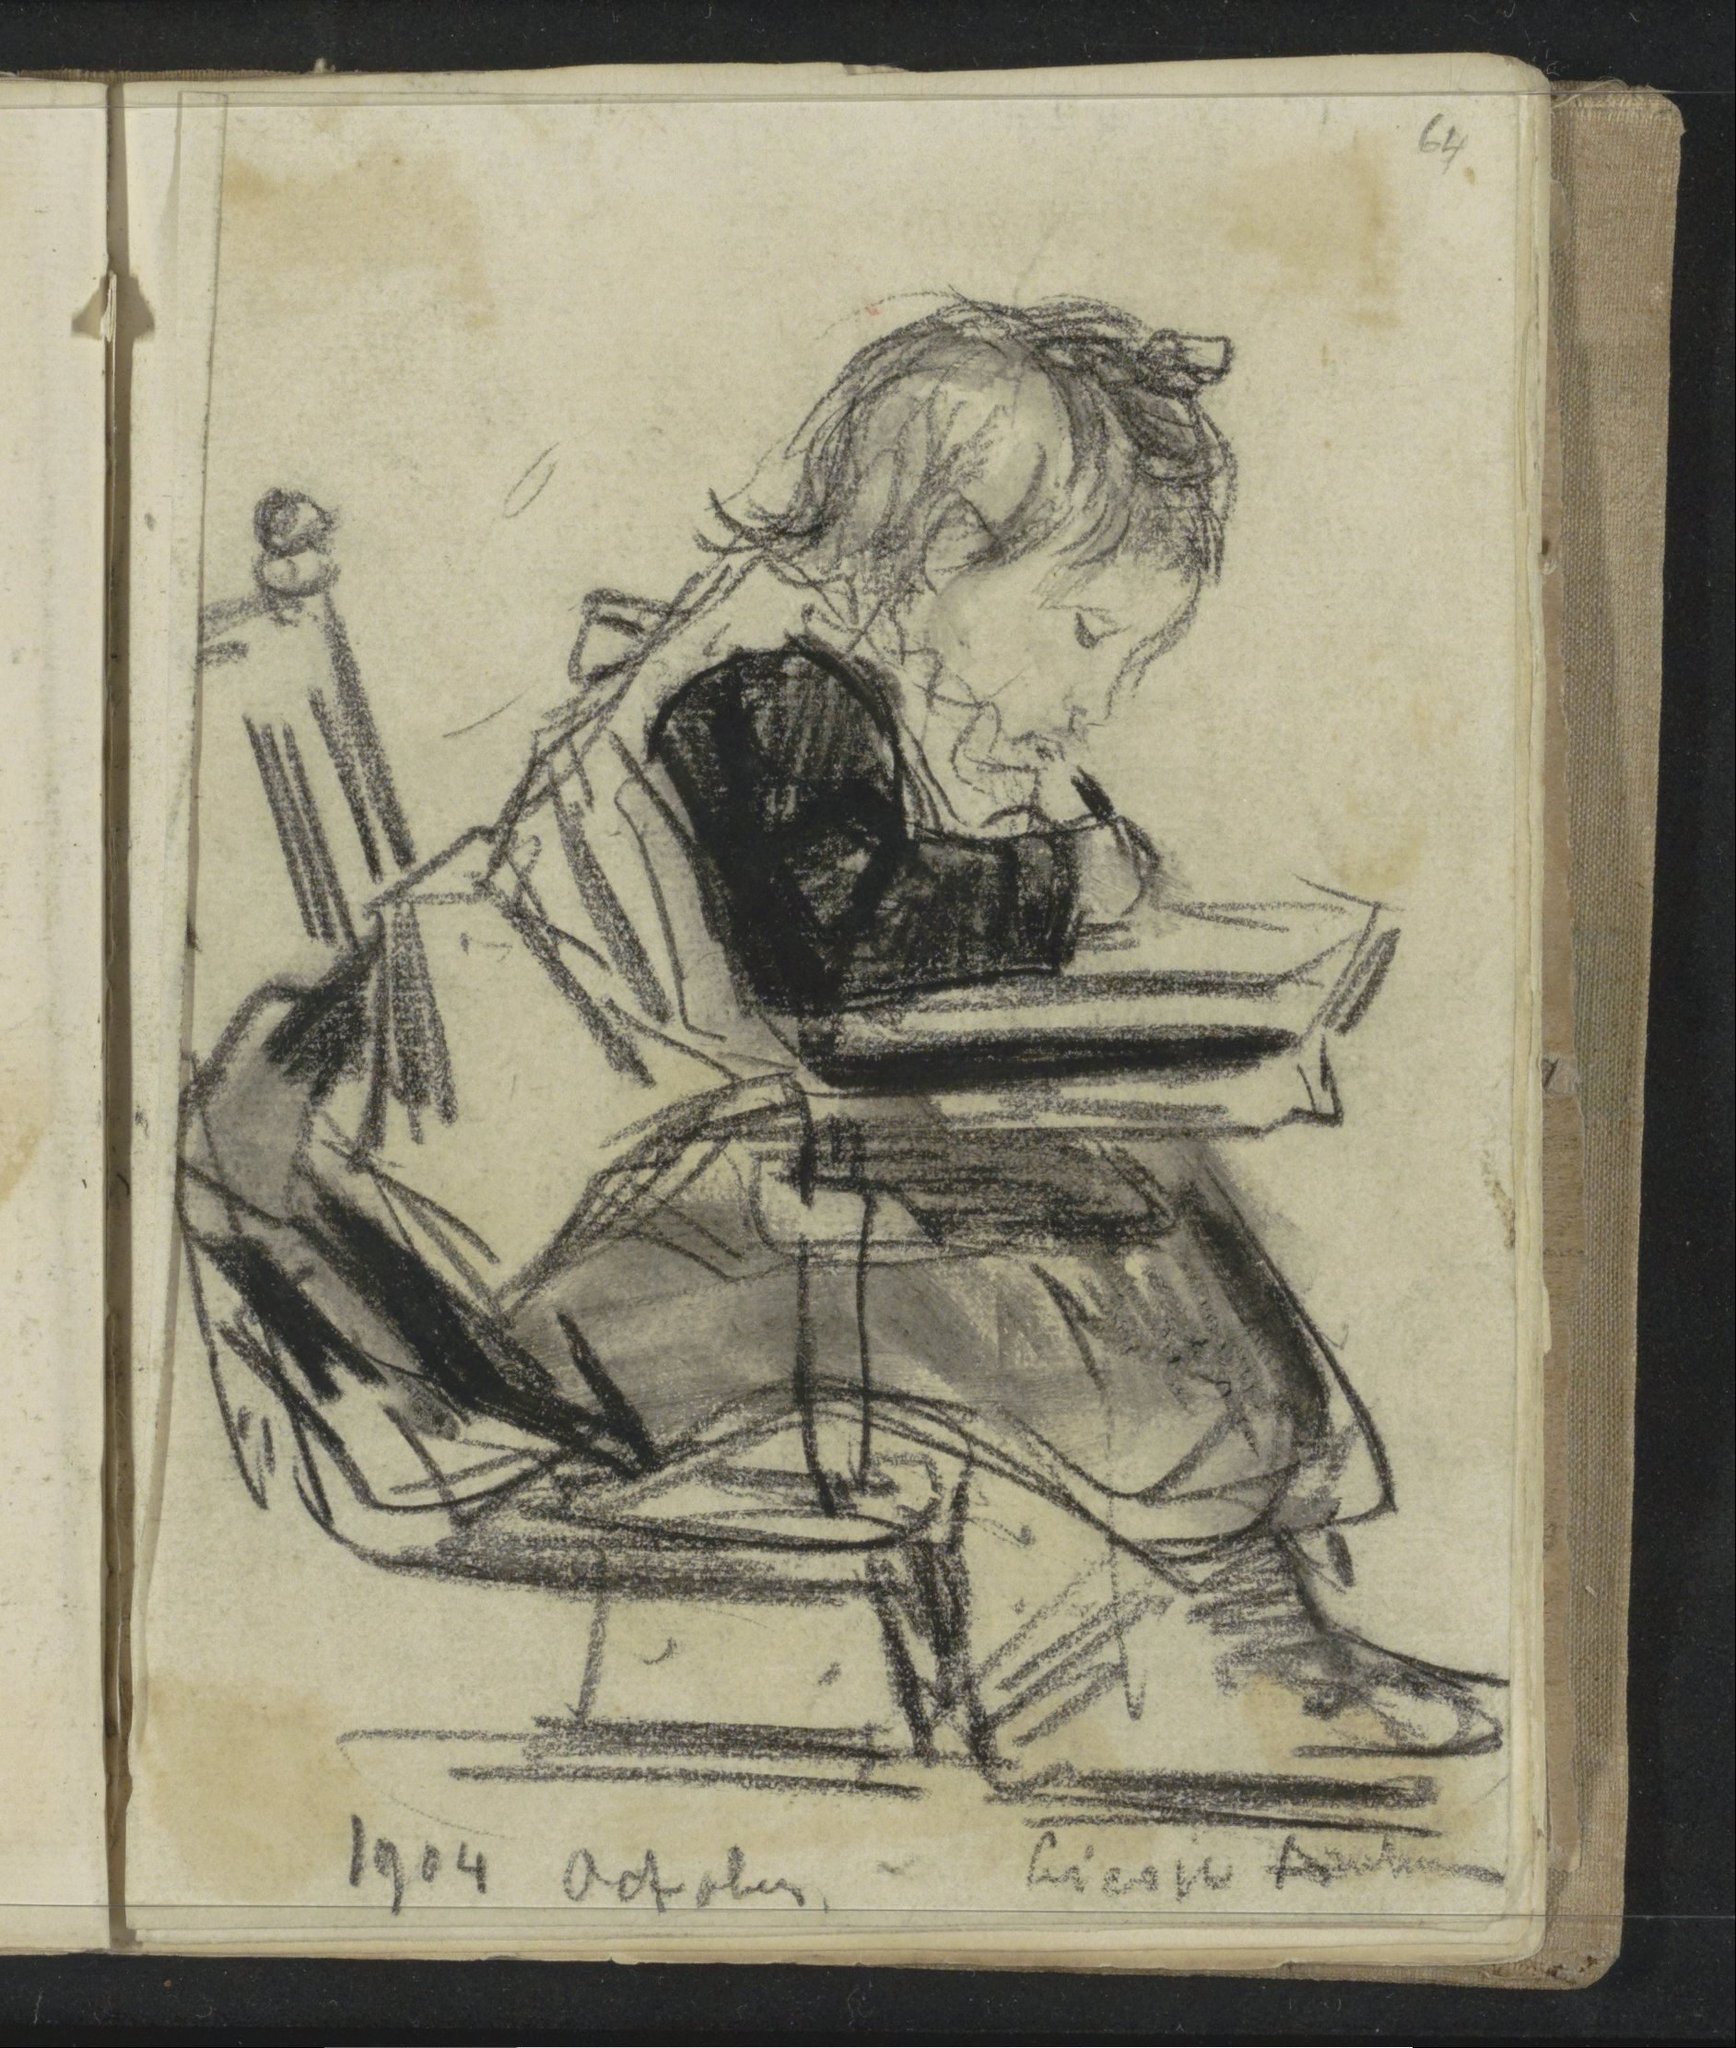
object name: sketchbook leaf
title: Portret van Elise (Liesje) Claudine Arntzenius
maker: floris arntzenius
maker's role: draughtsman, print maker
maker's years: 1864-1925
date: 1904-1910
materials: chalk, paper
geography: the hague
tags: painter, writing-table, writing-desk, child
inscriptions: date: ‘1904 October’, name: ‘Liesje Arntzenius’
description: Het kind, de dochter van de kunstenaar, zit aan een schrijftafel. Blad, geplakt op pagina 64 uit een schetsboek met 82 pagina's.